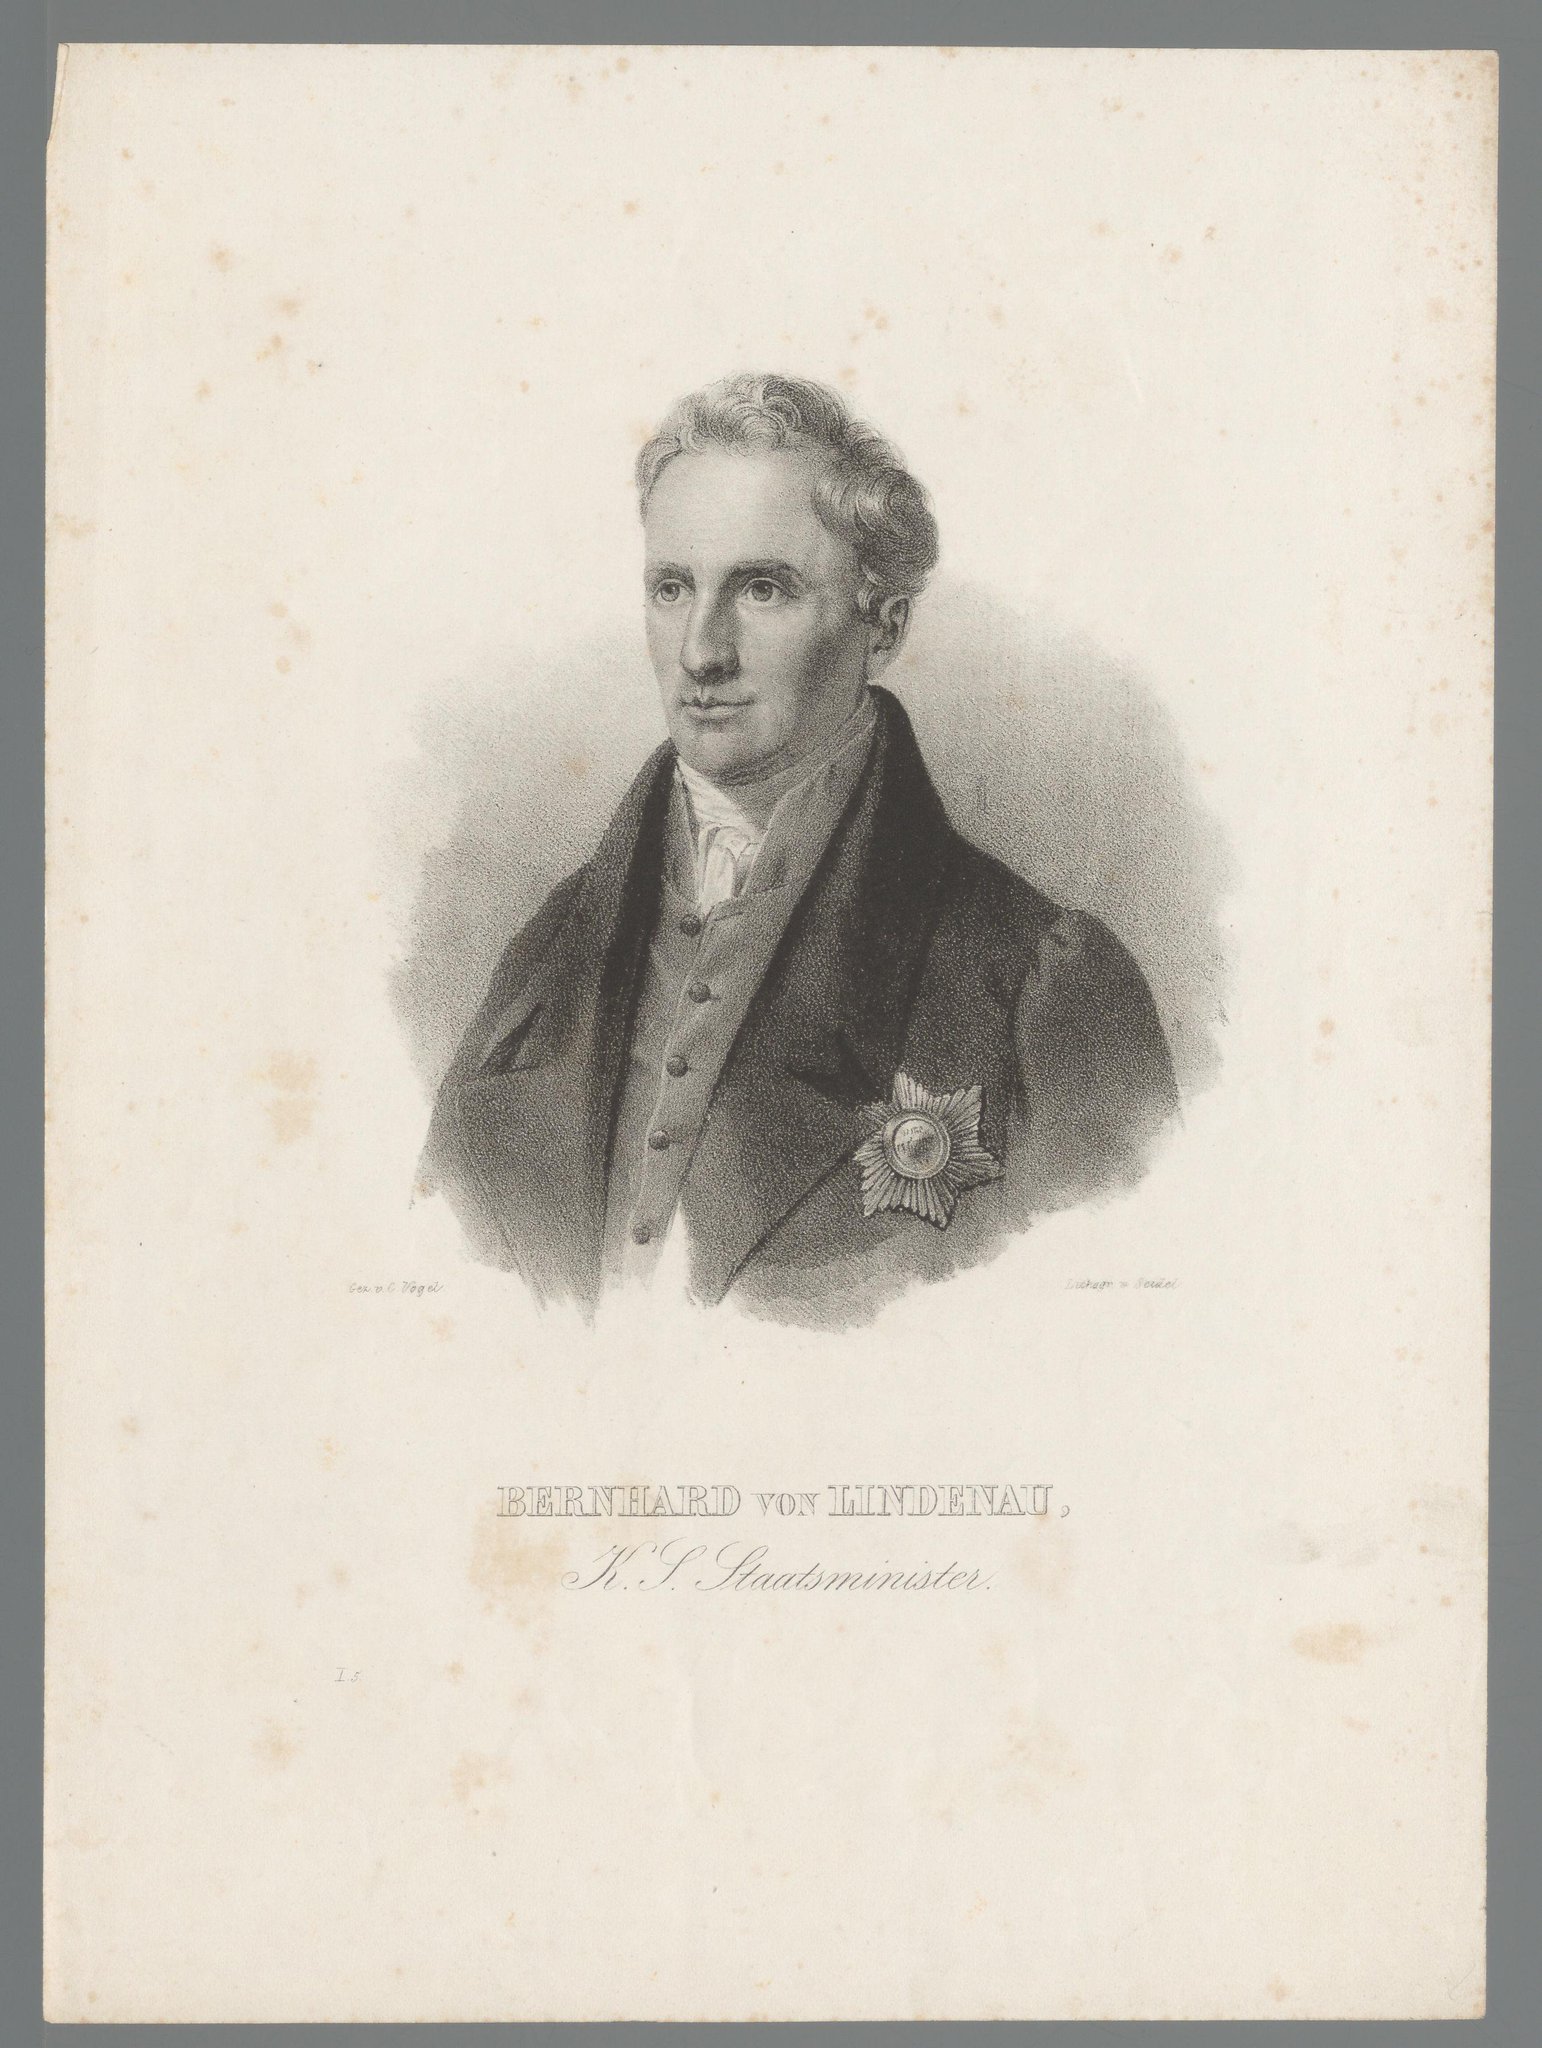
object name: print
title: Bernhard von Lindenau, K.J. Staatsminister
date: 1830-1875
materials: paper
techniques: lithograph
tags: adult man, historical persons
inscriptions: collector's mark: Lugt 2228